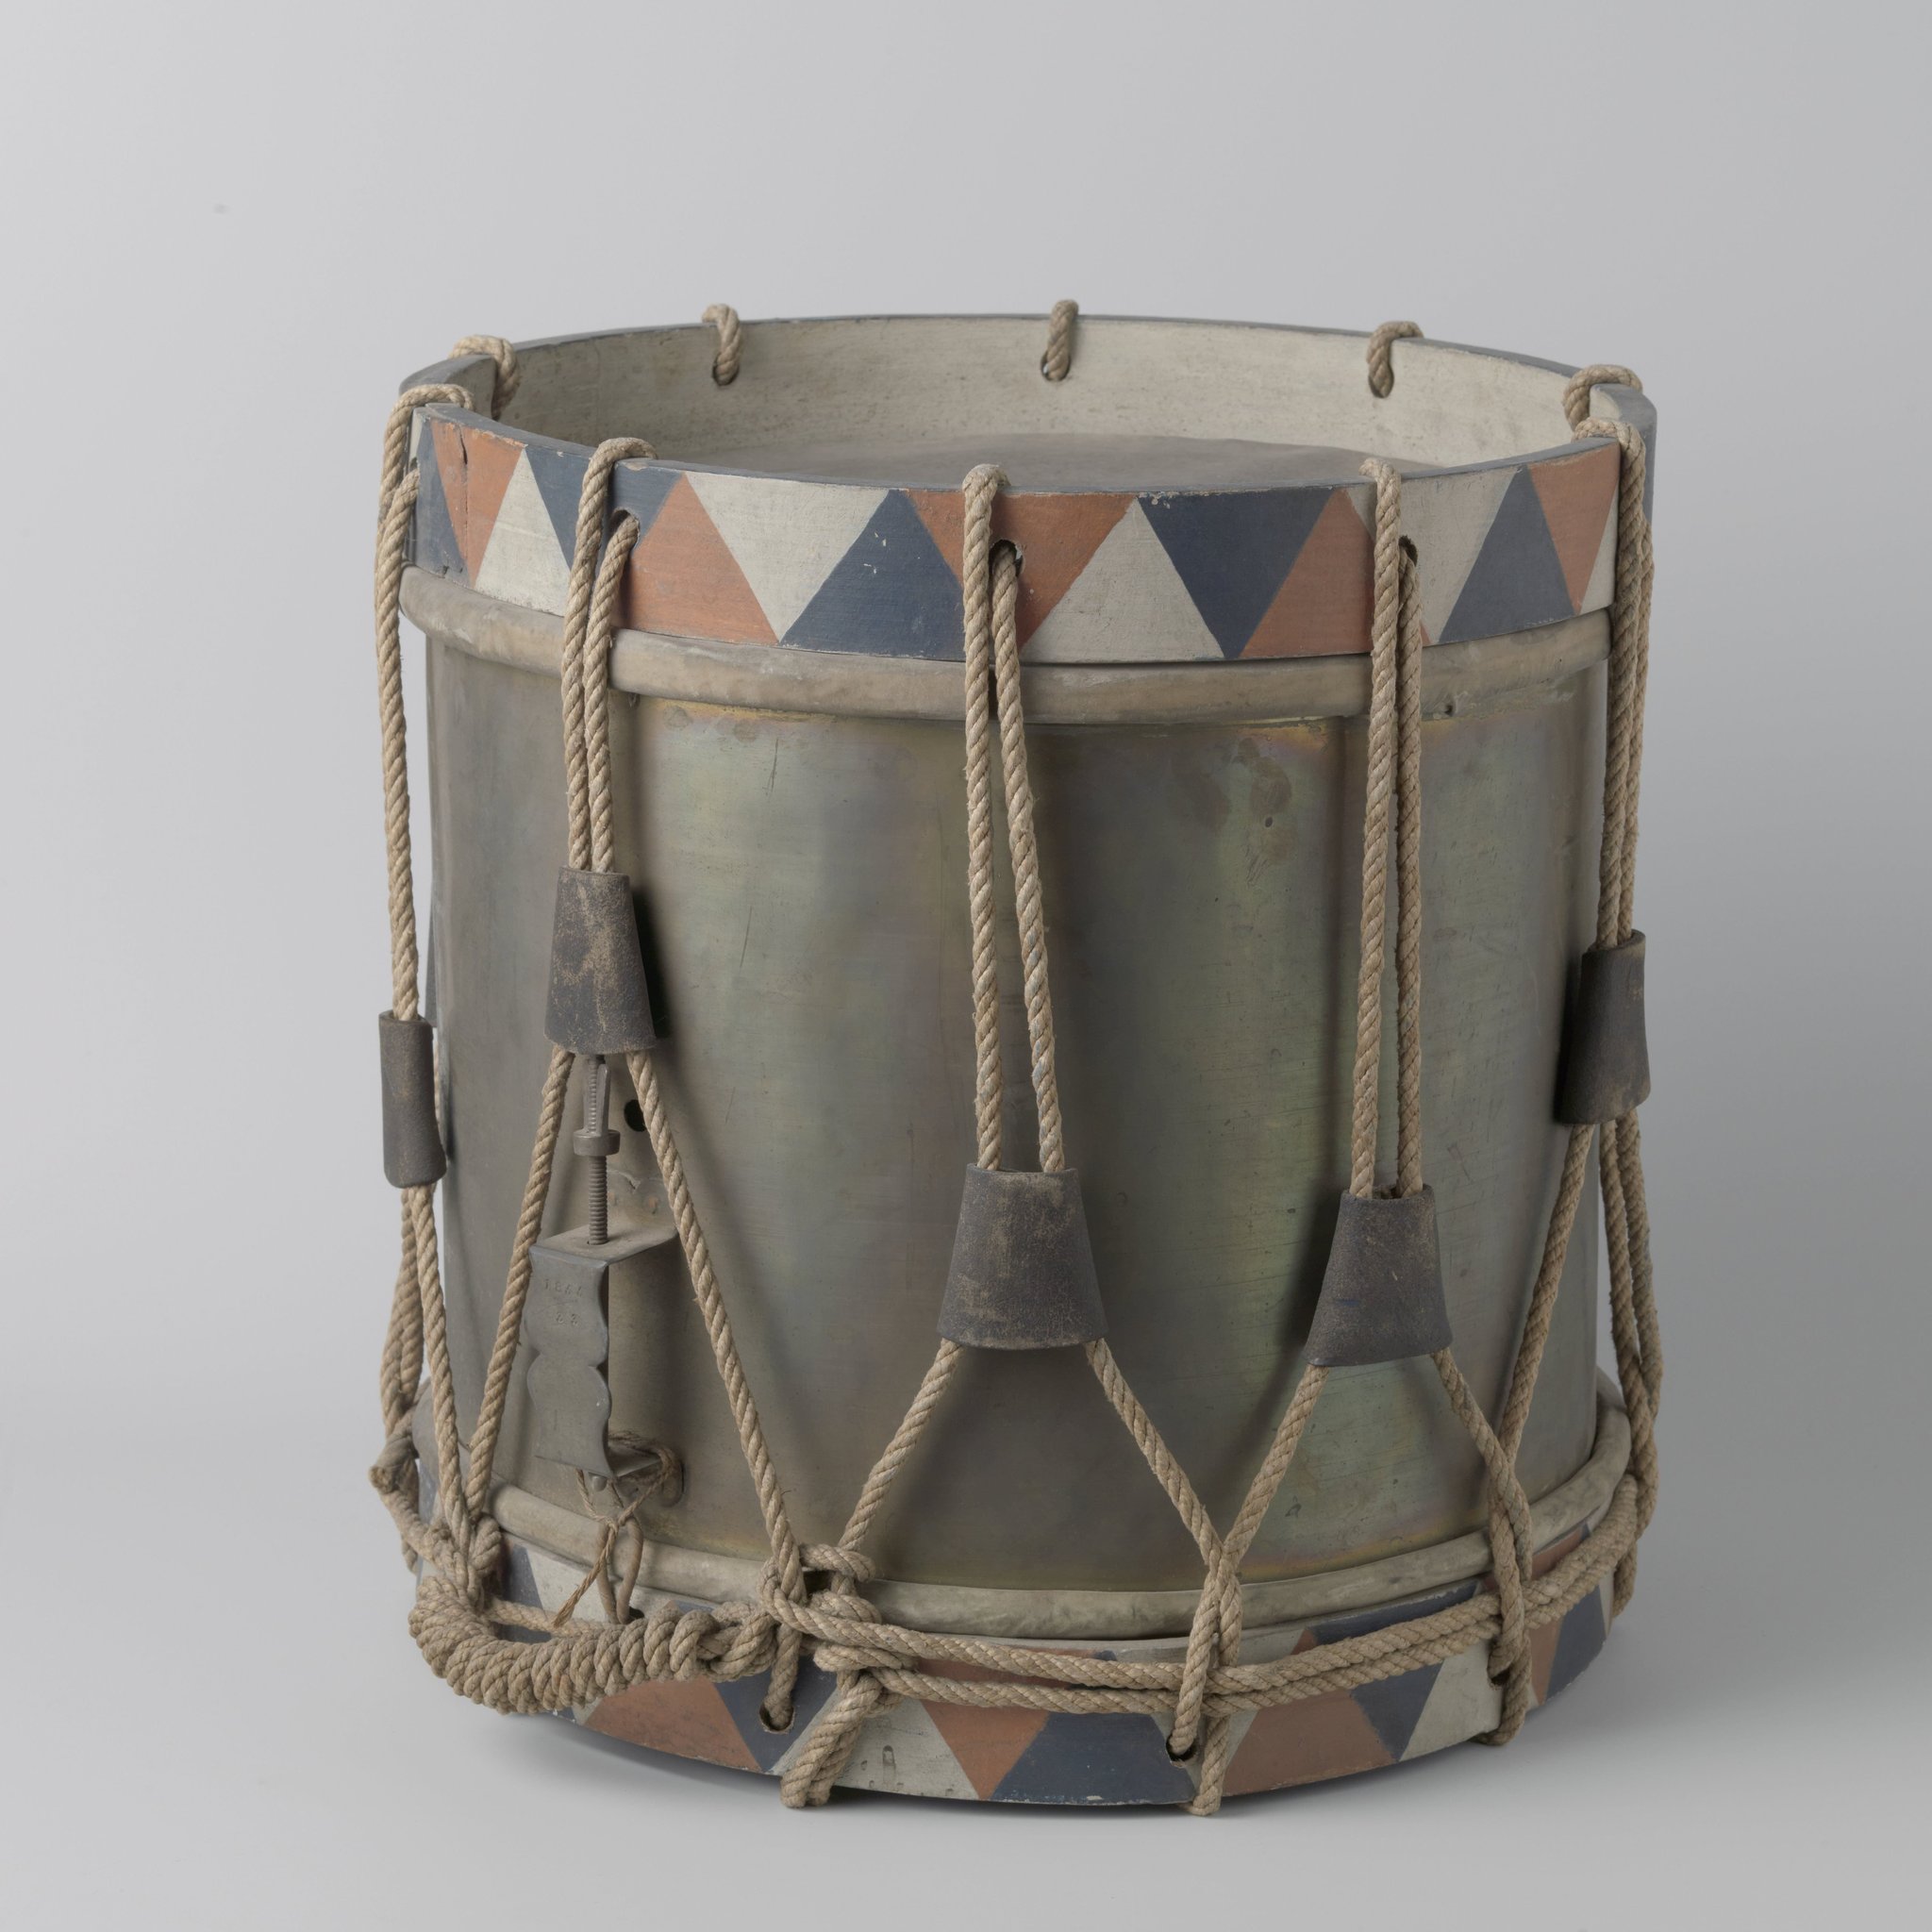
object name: drum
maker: Anonymous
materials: brass, leather, fiber, wood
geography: netherlands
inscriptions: inscription: ‘1855-33’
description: Music has always been a crucial element of public celebrations, such as military parades, coronations, royal weddings, and funerals, adding grandeur to the solemnity of the occasion. Musical ensembles entrusted with performing music at these events have existed in Europe since the Middle Ages. This display highlights various marching bands and their musical instruments dating from the 16th to the 19th century.